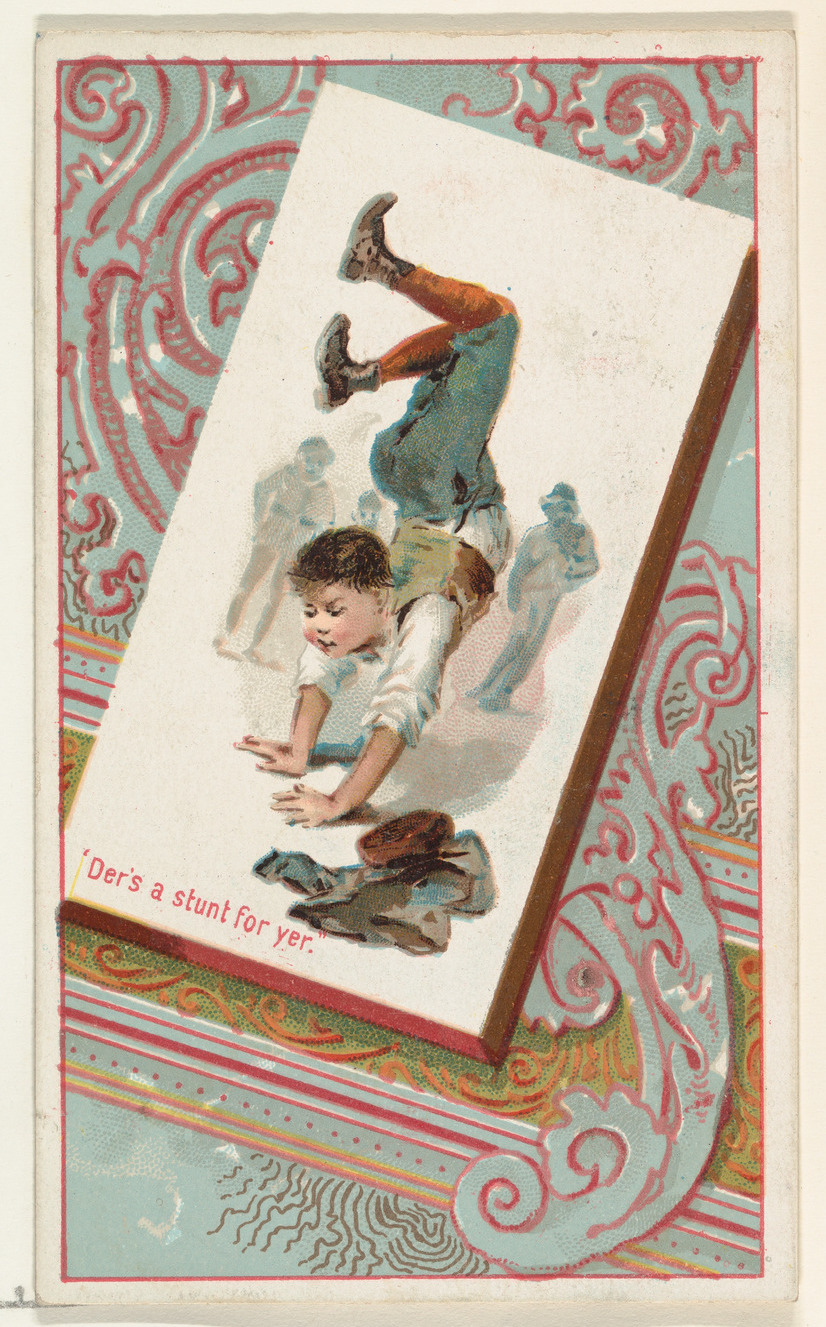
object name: print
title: "Der's a stunt for yer," from the Terrors of America set (N136) issued by Duke Sons & Co. to promote Honest Long Cut Tobacco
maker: w. duke, sons & co.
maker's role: publisher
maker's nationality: american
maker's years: 1870-1920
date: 1888-1889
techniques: color lithograph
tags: boys